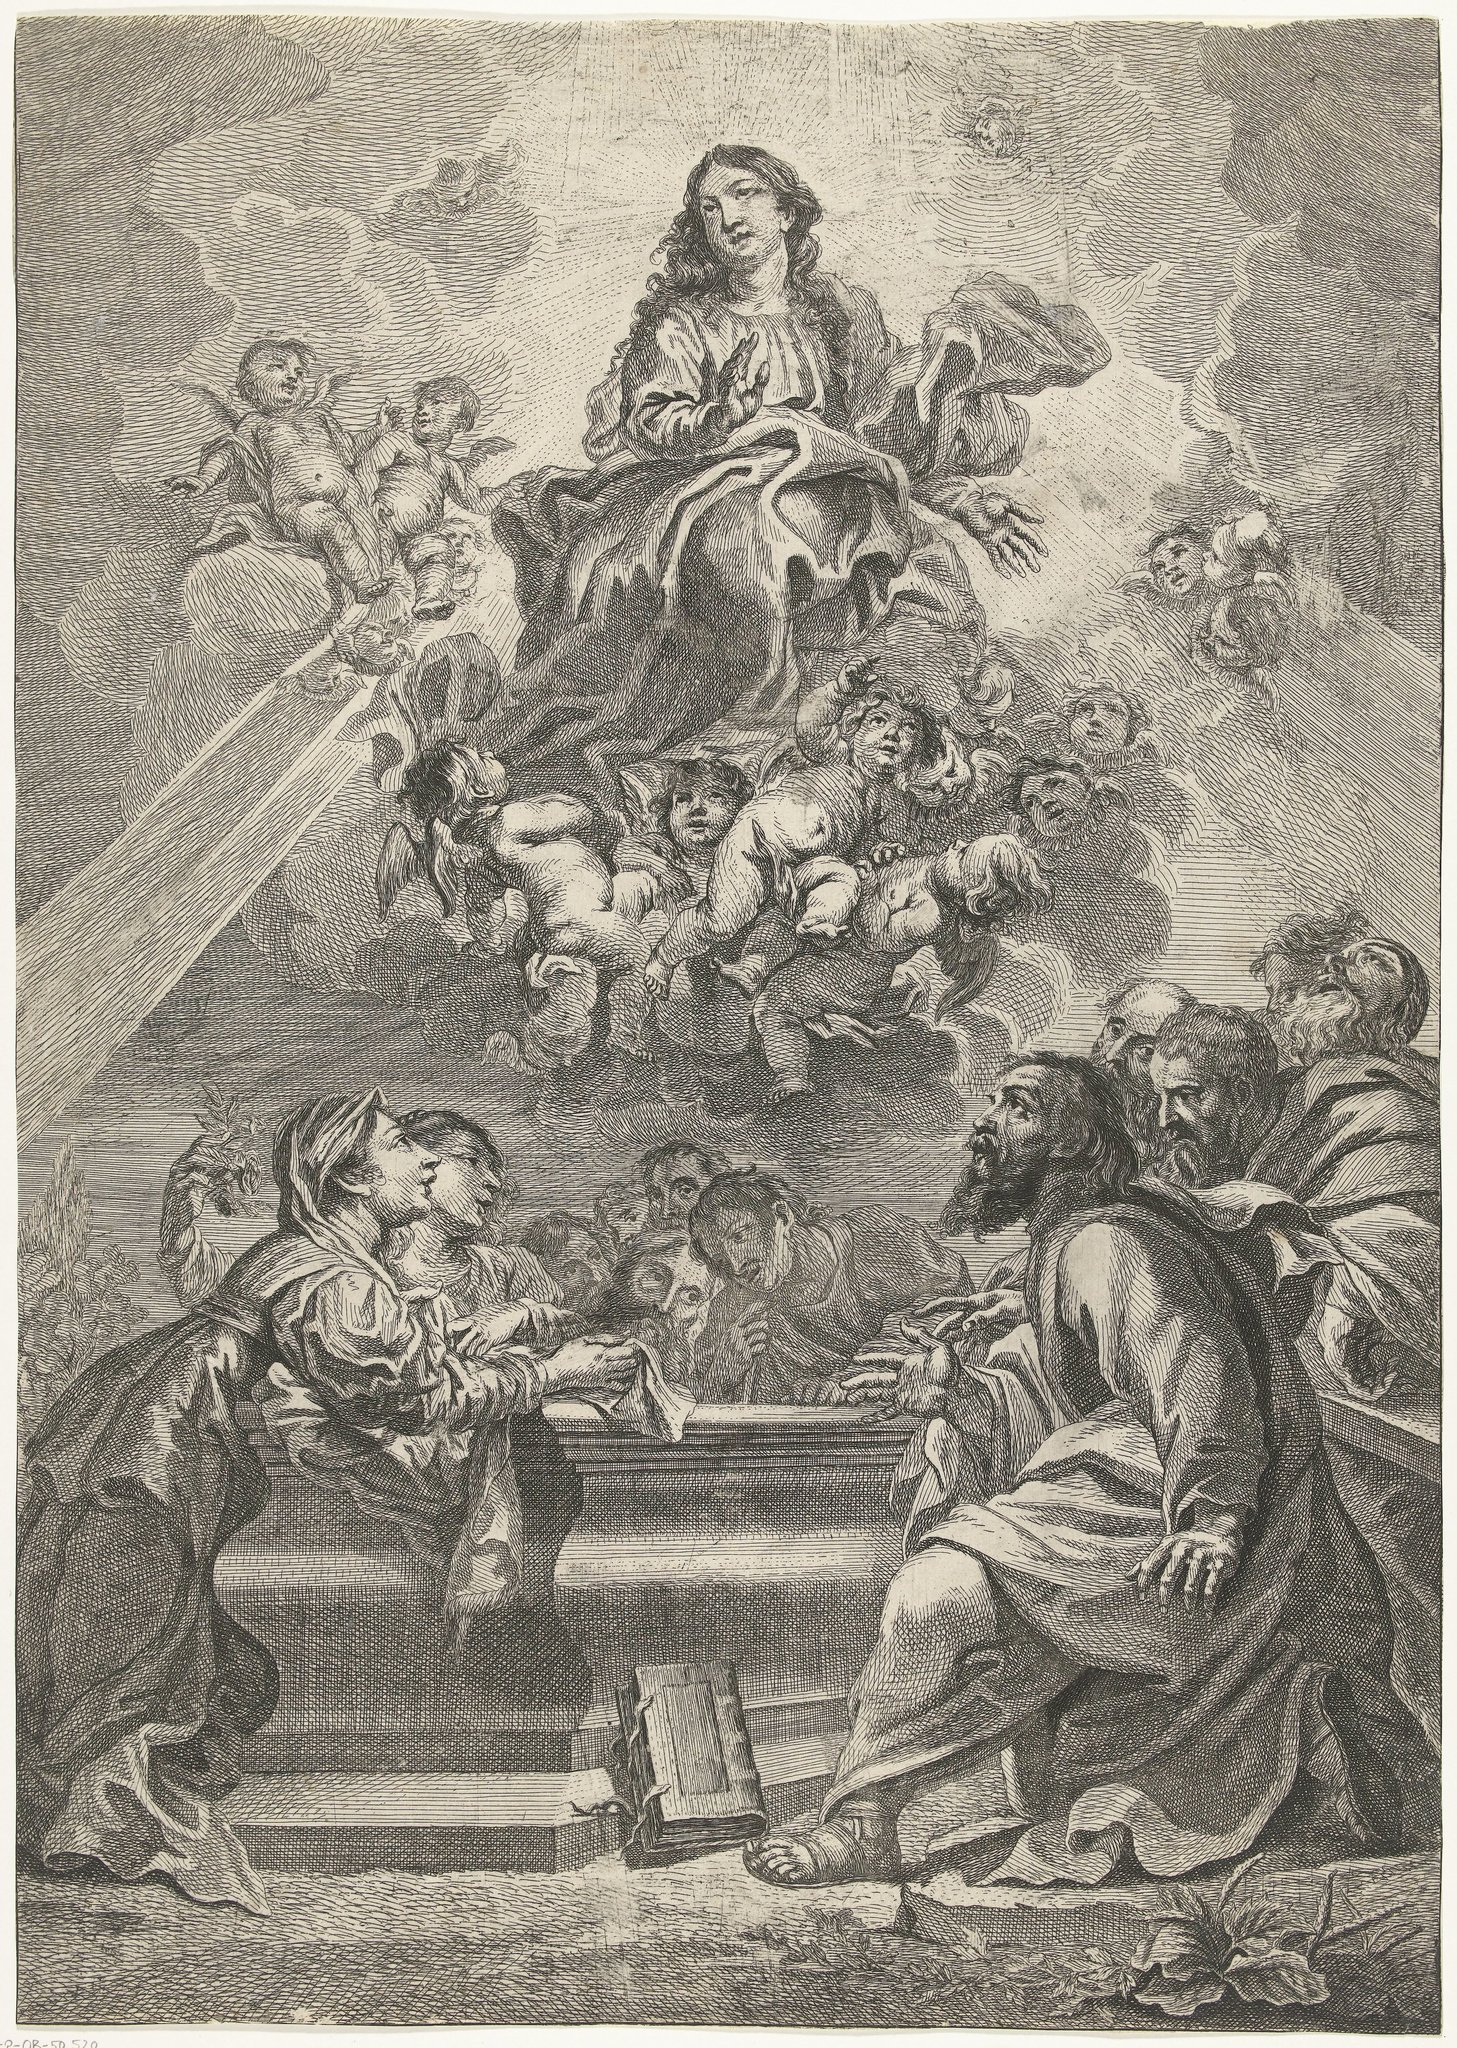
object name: print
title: Hemelvaart van Maria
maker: remoldus eynhoudts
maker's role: print maker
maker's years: 1613-1680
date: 1626-1680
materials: paper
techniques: etching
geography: antwerp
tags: the assumption of mary ('assumptio corporis'): she is borne into heaven by angels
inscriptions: collector's mark: Lugt 240